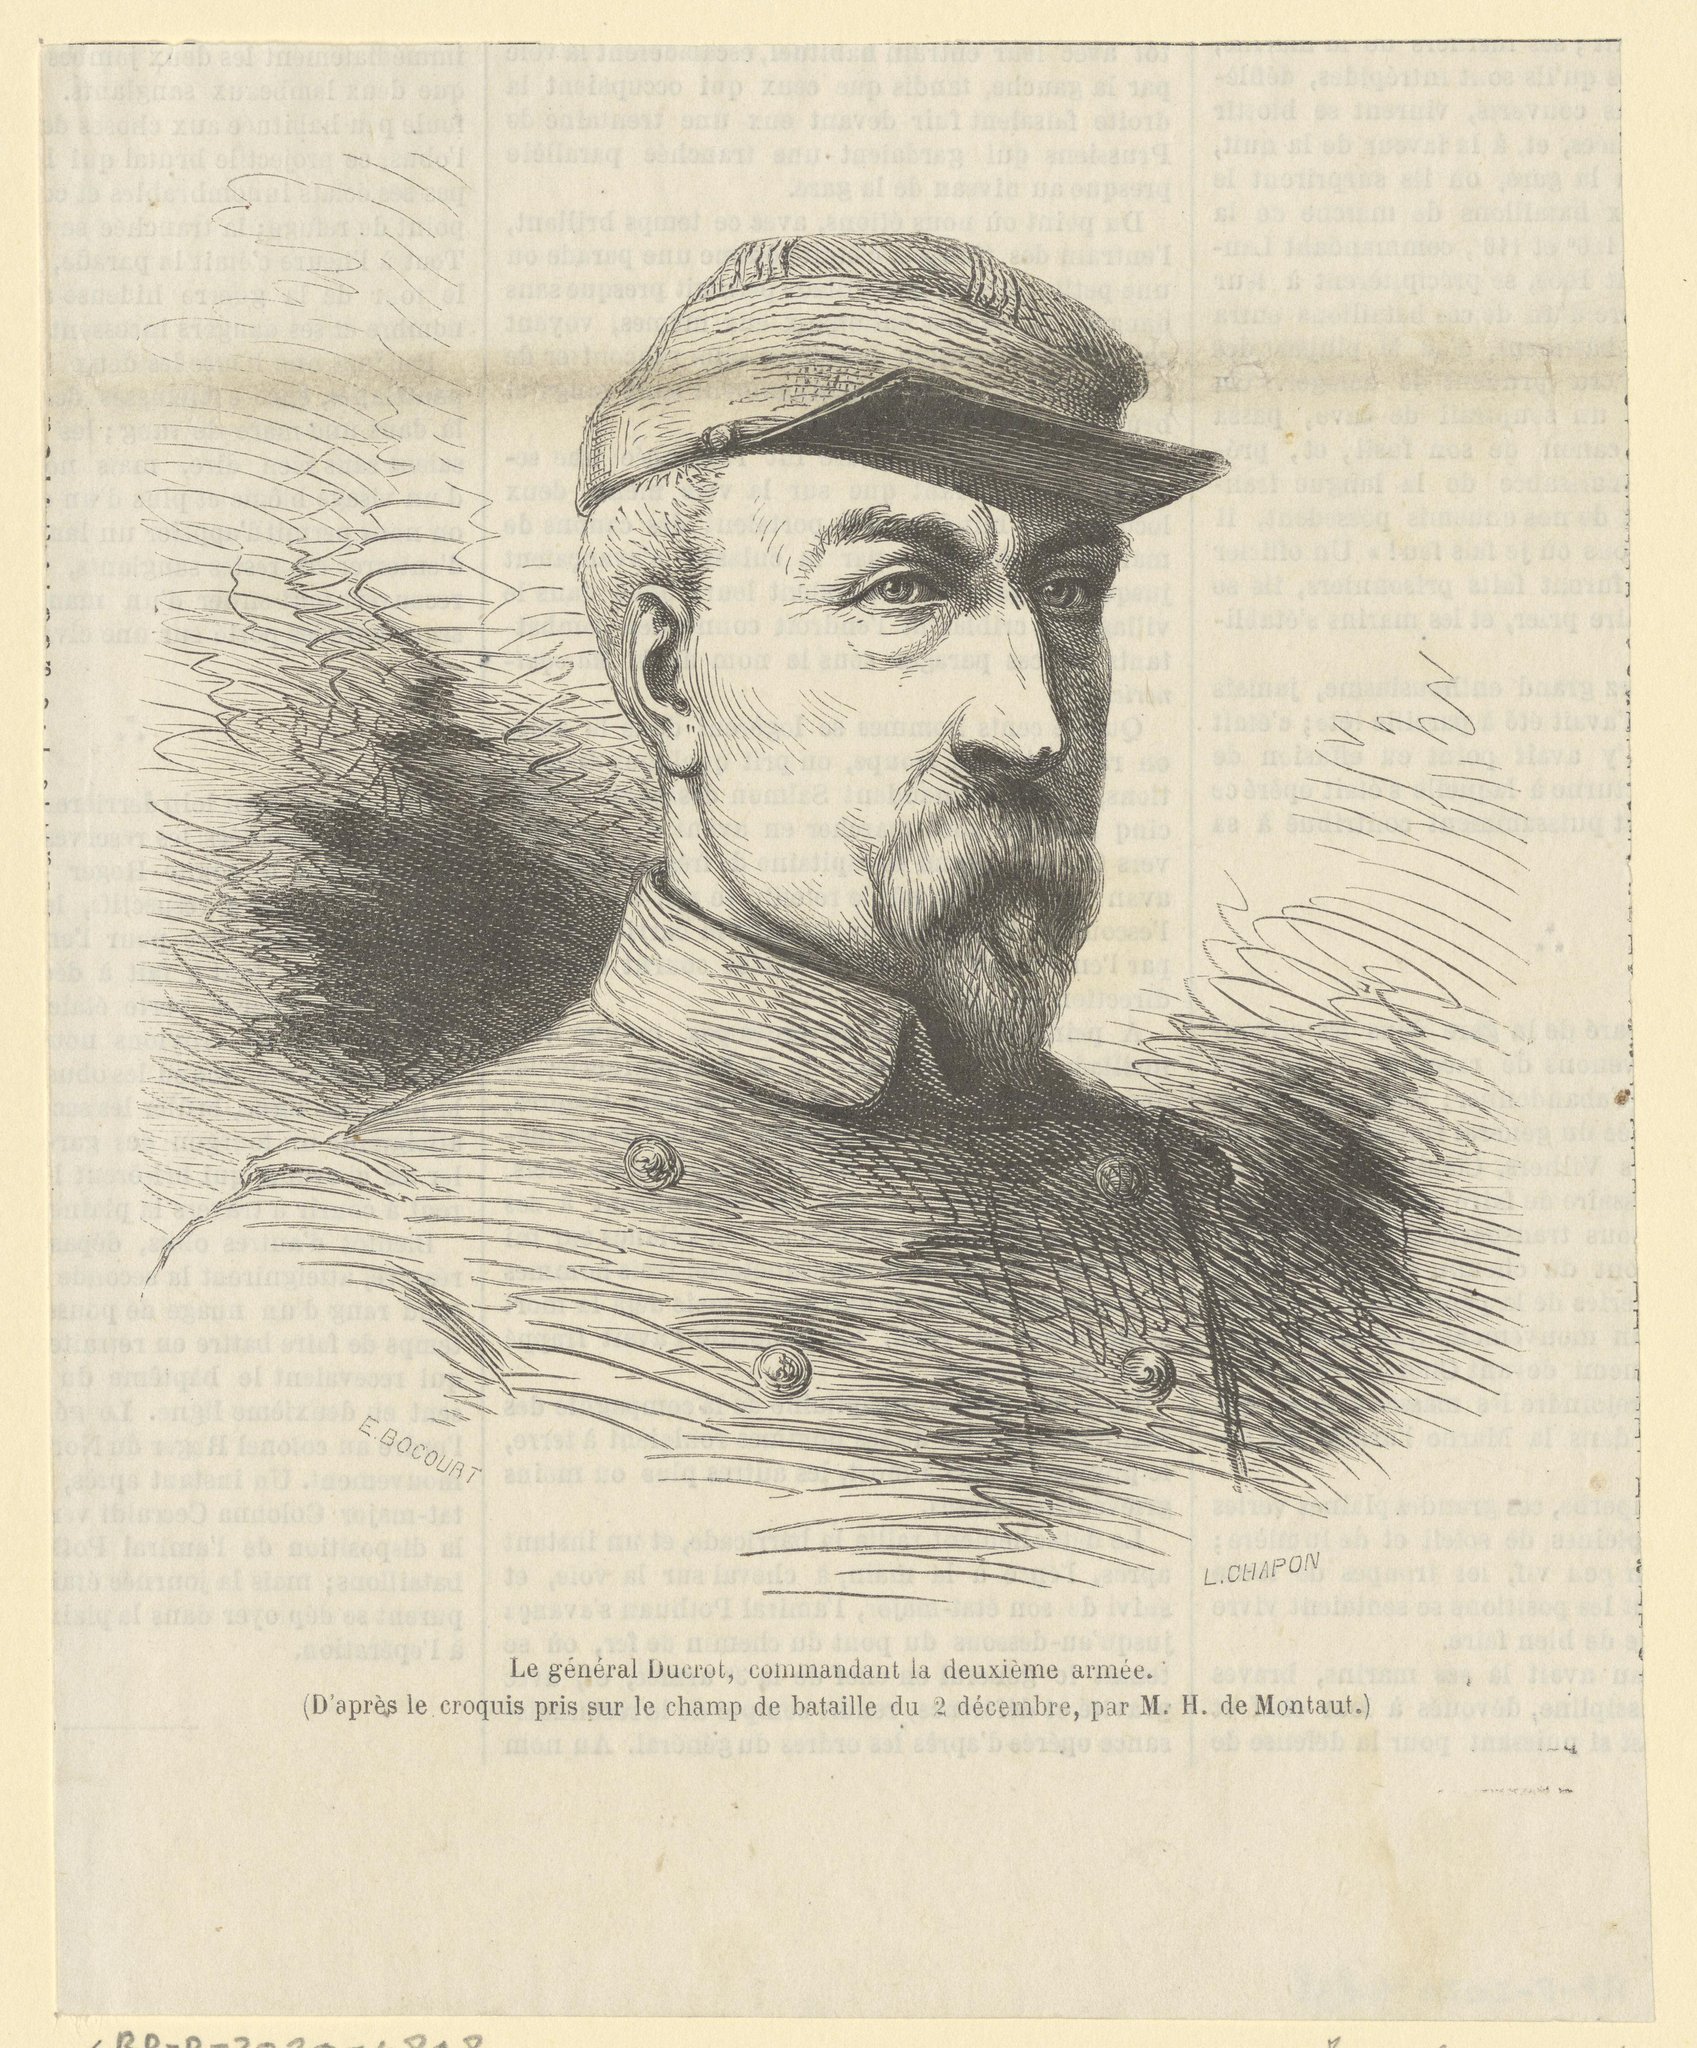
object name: print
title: Portret van Auguste Alexandre Ducrot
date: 1870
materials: paper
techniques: letterpress printing, engraving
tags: commander-in-chief, general, marshal, historical persons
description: Prent uit: Le Monde Illustré 14 (1870), nr. 713, 10 december 1870.